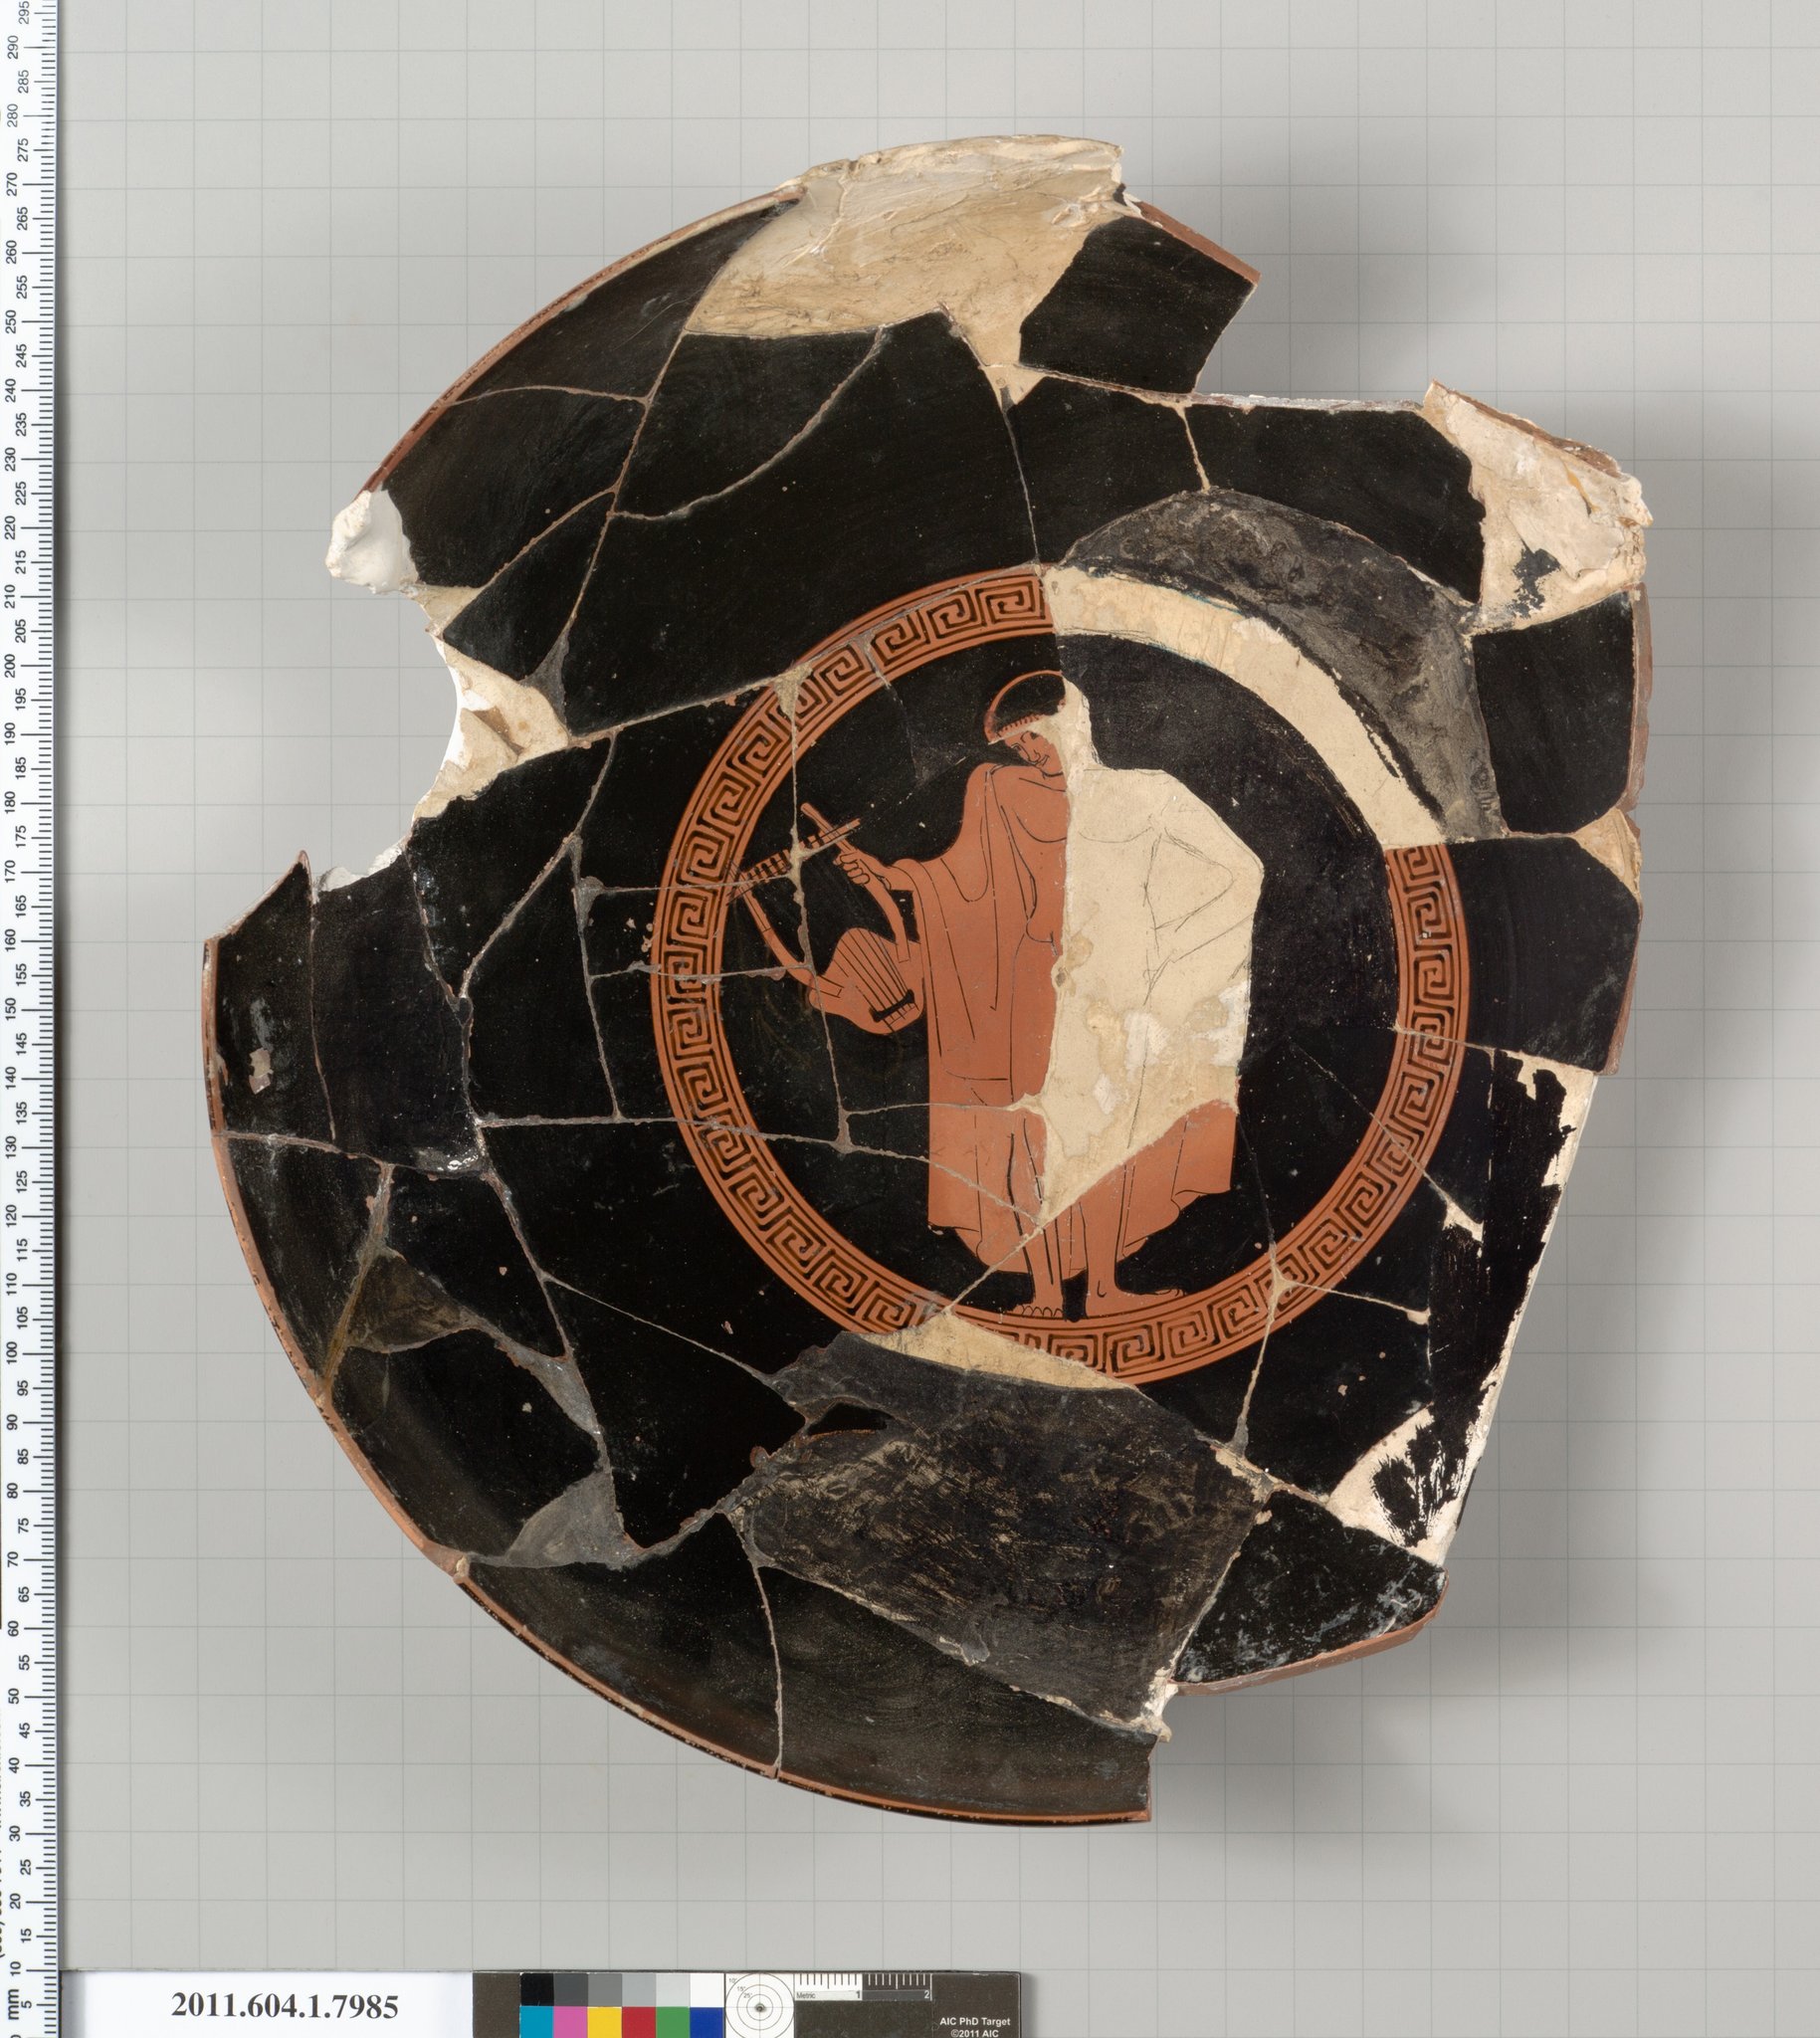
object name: kylix fragment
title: Terracotta fragment of a kylix (drinking cup)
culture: greek, attic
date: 475-451 BCE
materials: terracotta